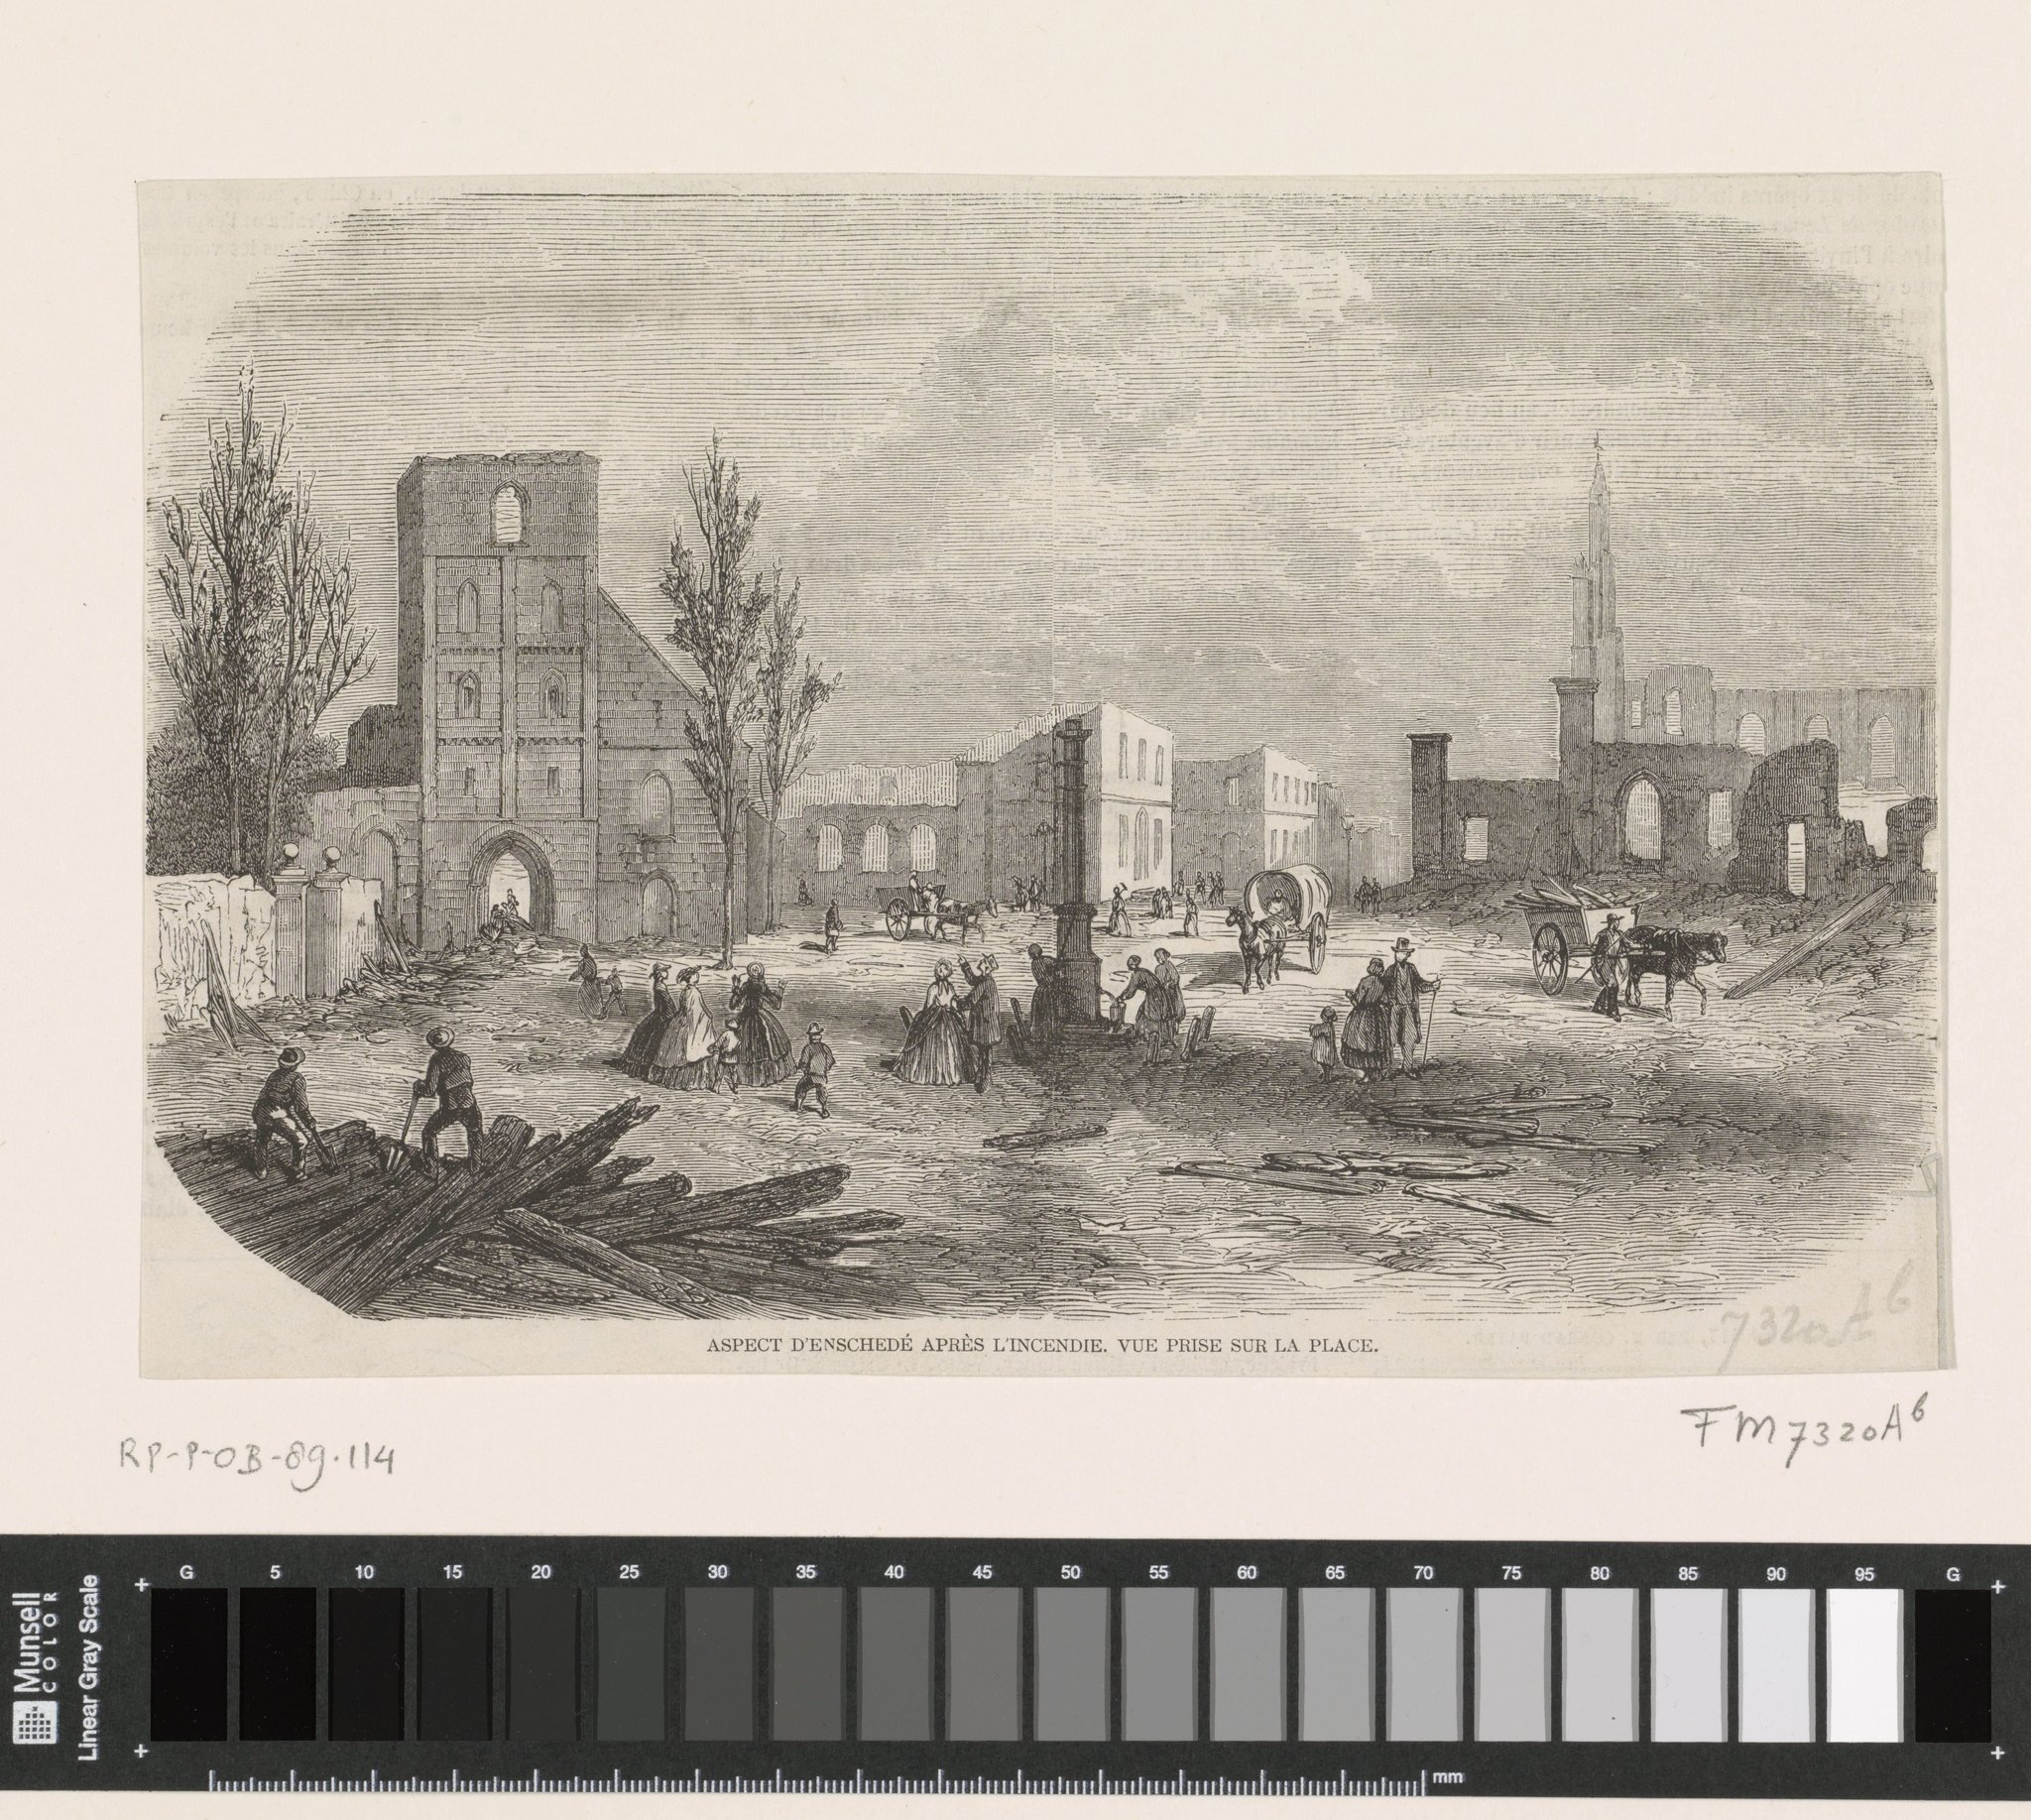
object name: print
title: Aspect d'Enschedé après l'incendie, vue prise sur la place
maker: monogrammist pb (houtgraveur)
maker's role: print maker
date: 1862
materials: paper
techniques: engraving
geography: france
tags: ruin of a building ~ architecture, ruin of a dwelling, house, castle, etc.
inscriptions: collector's mark: Lugt 2228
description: Gezicht op de ruïnes na de grote brand te Enschedé op 7 mei 1862. Blad genomen uit een tijdschrift of boek, op de achterzijde bedrukt met tekst.